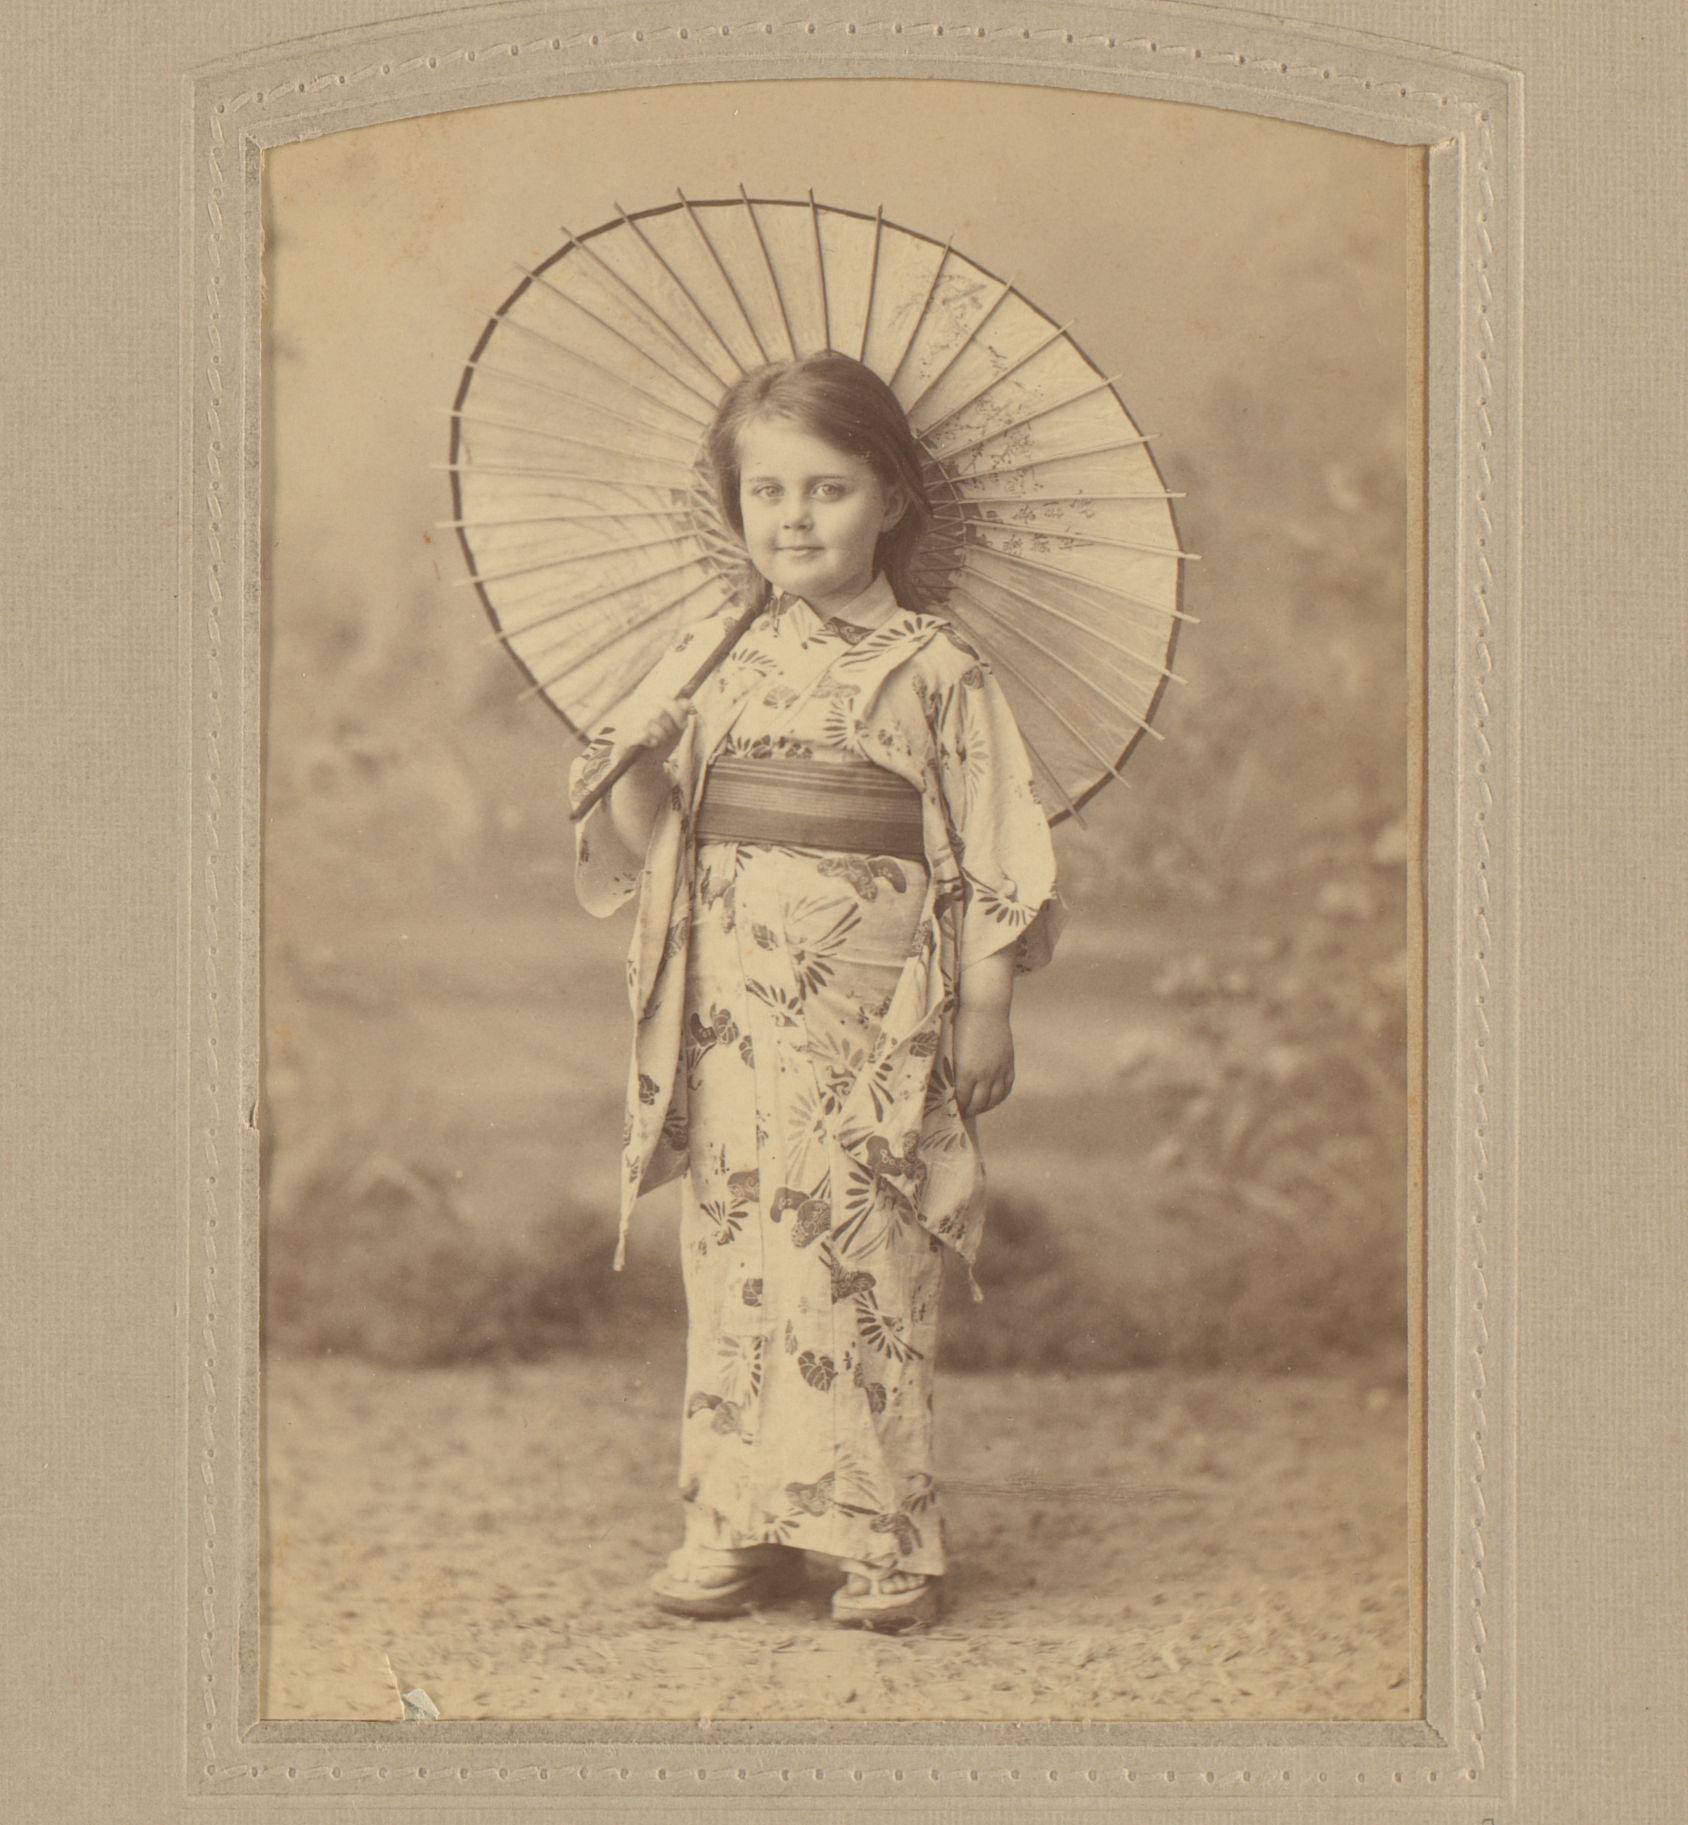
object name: photograph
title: Studioportret van een klein meisje in kimono met parasol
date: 1890-1898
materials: paper, photographic support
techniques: albumen print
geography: netherlands